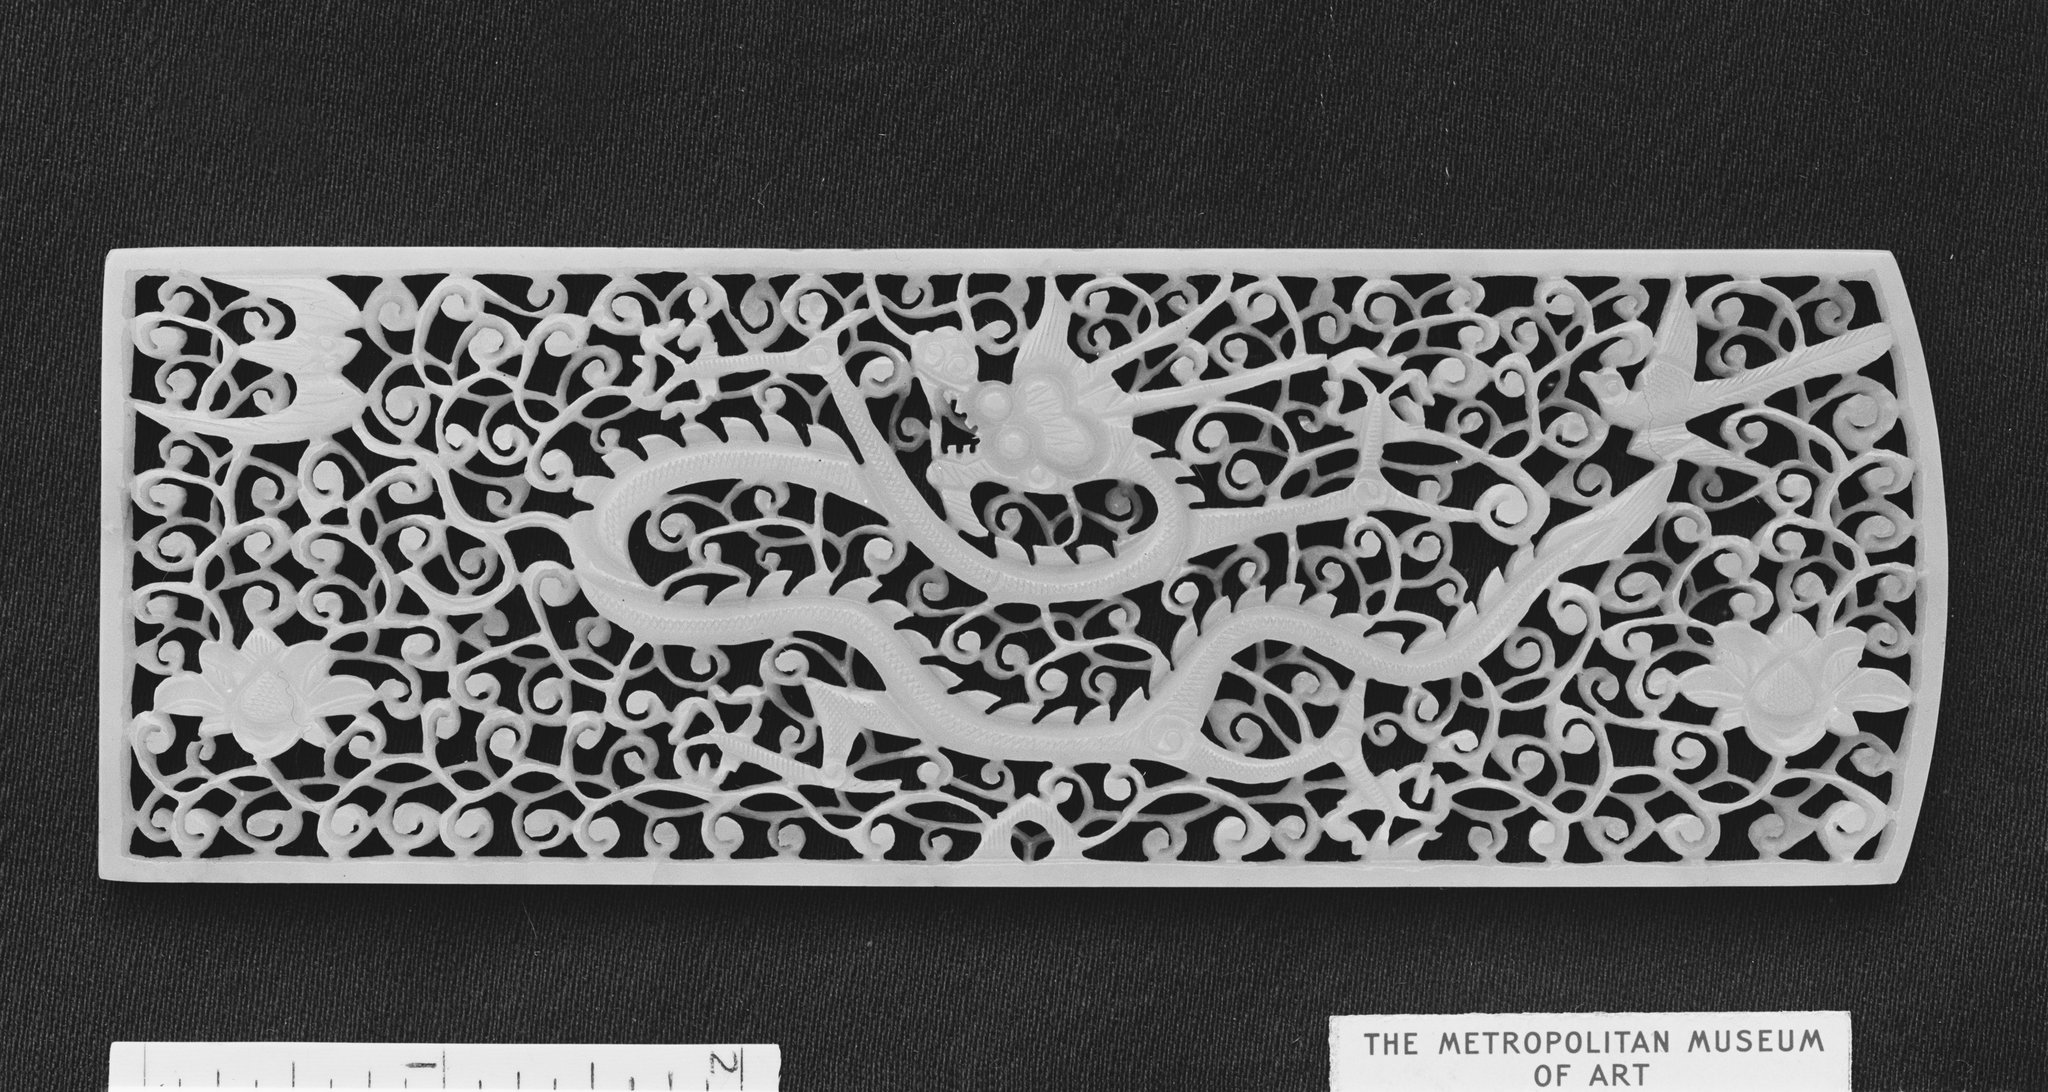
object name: belt plaque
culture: chinese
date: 1501-1600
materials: jade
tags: flowers